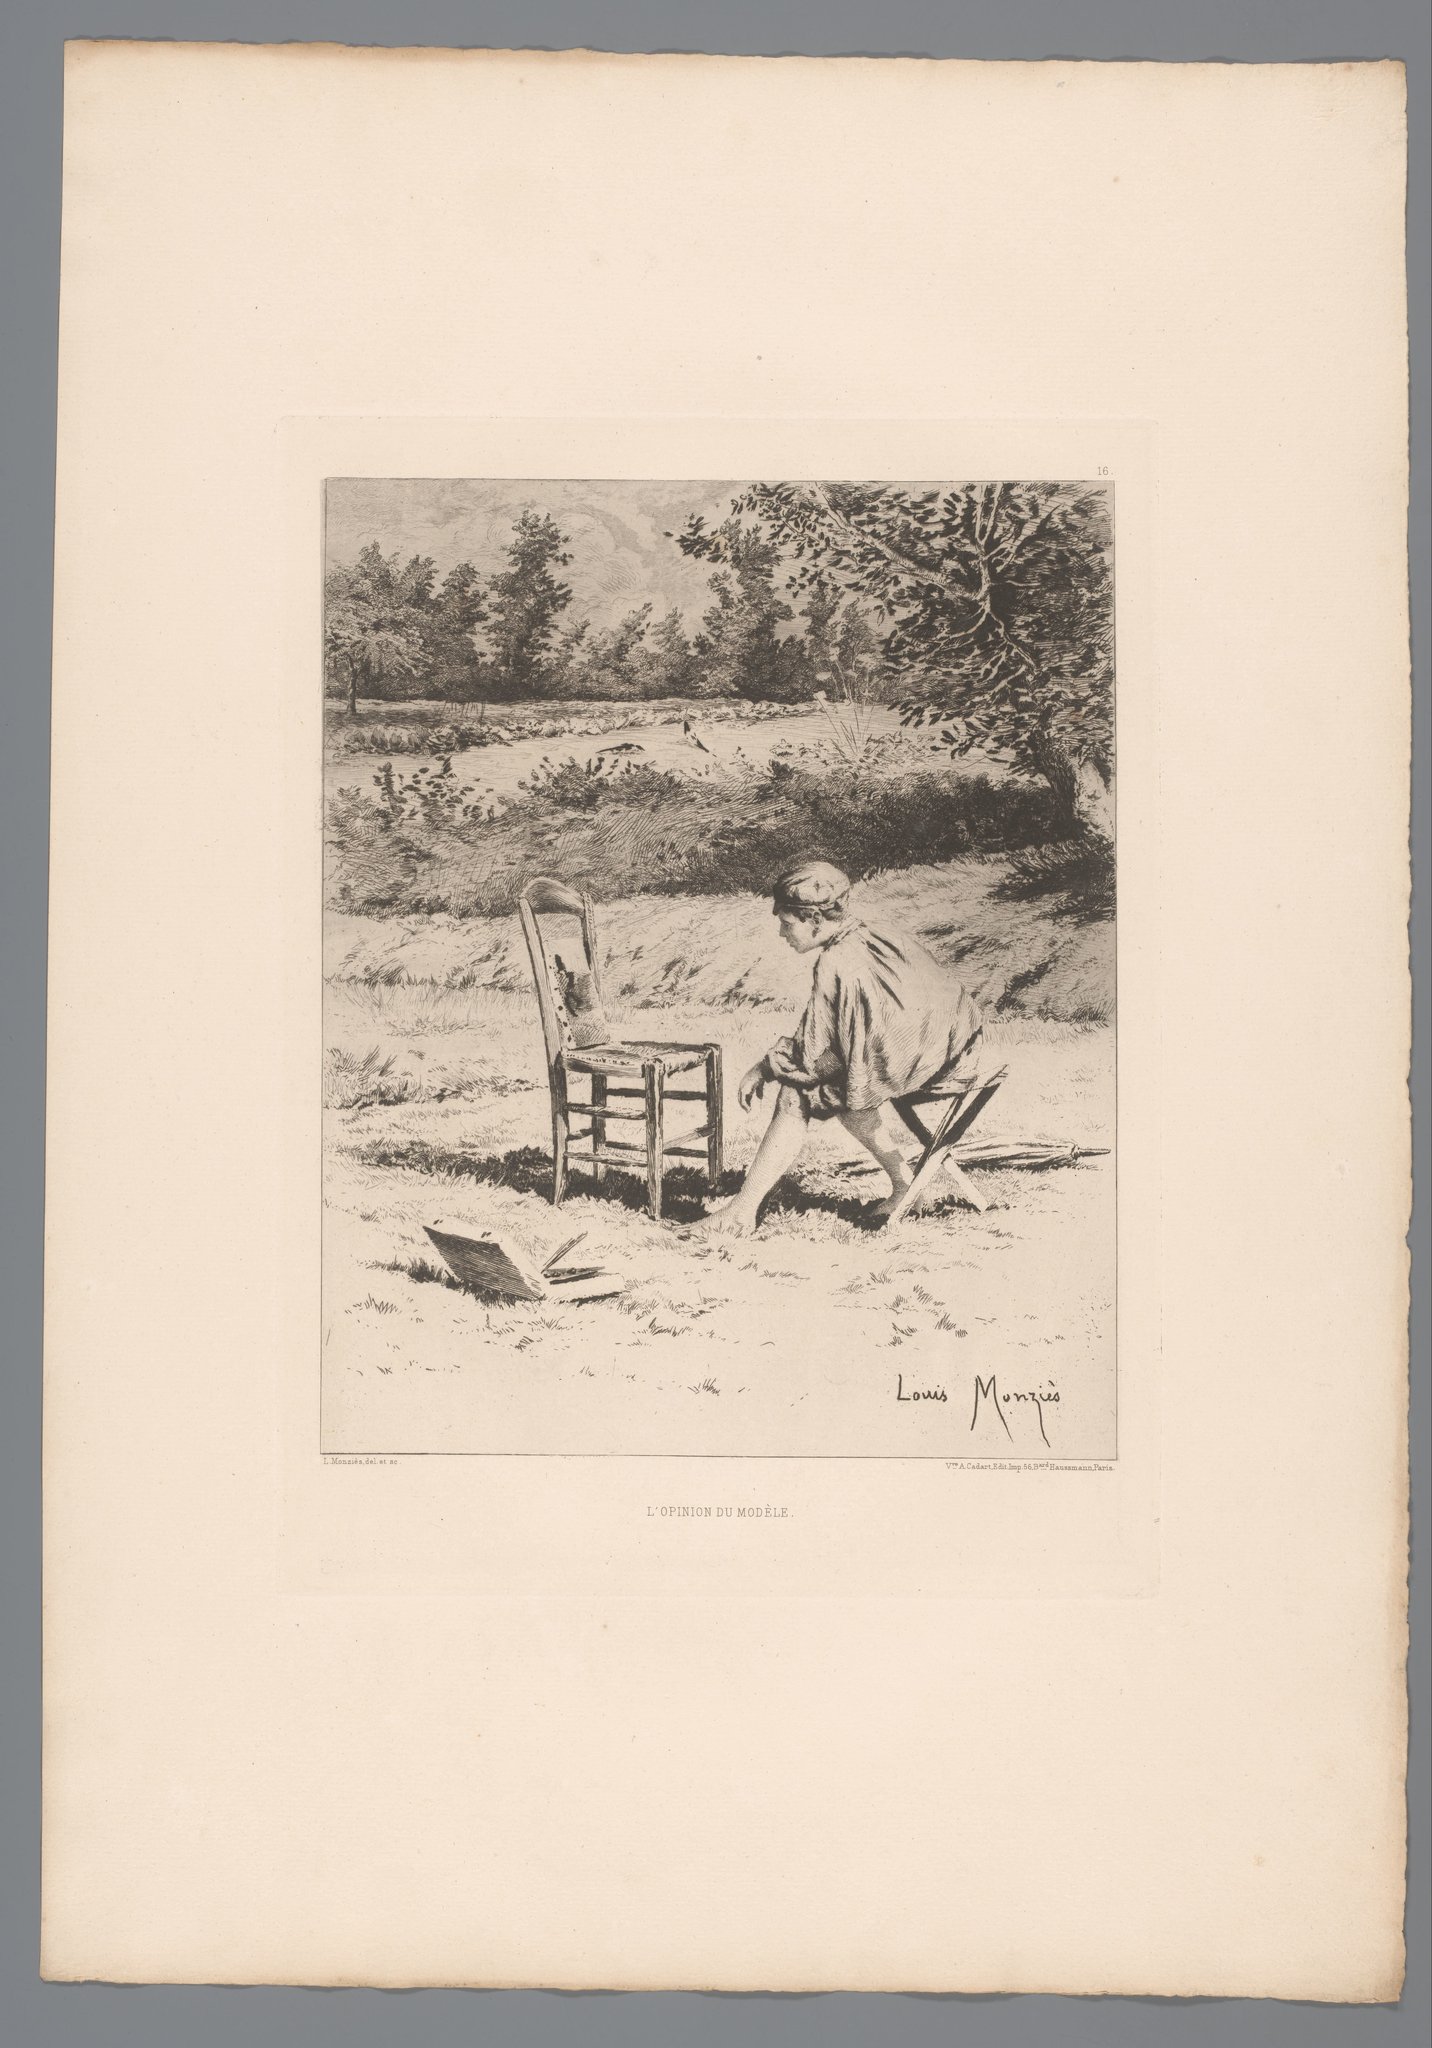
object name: print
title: L'eau-forte en 1878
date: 1878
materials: paper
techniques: drypoint, etching, intaglio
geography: paris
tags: model, sitter ~ painting - cc - out of doors, working situations ~ painter - cc - out of doors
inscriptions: collector's mark: ‘AFE v S’, collector's mark: Lugt 2760, collector's mark: Lugt 2228, watermark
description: Zittende jongen bekijkt een schilderij waarvoor hij model heeft gestaan.